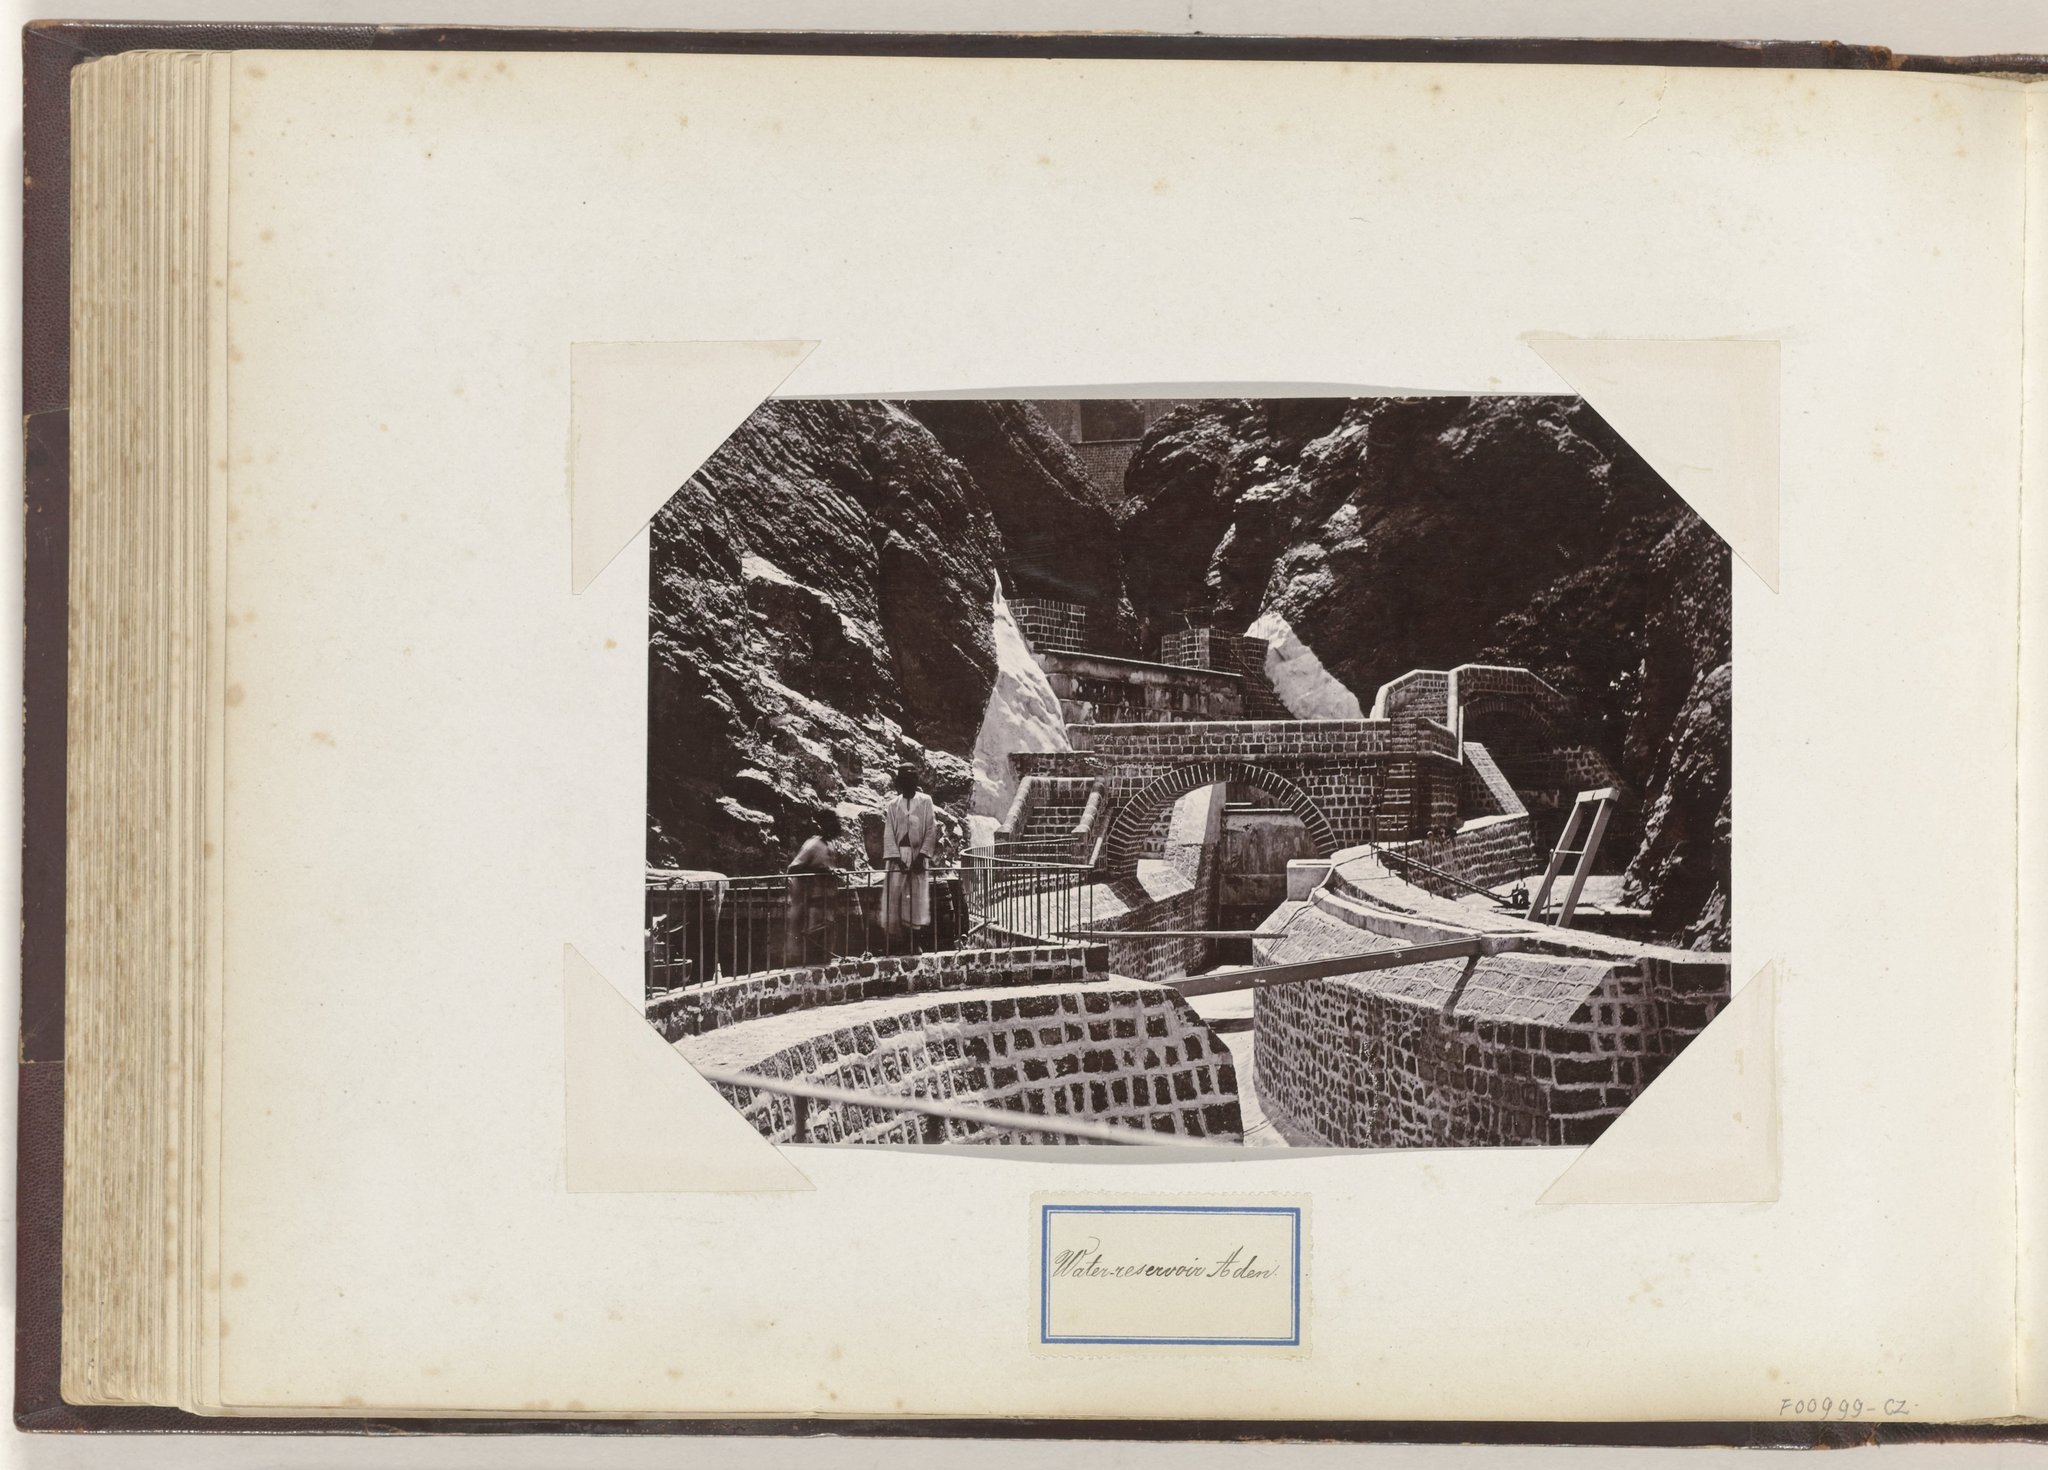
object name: photograph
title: Water-reservoir Aden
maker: Anonymous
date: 1880-1920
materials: paper, photographic support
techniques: gelatin silver print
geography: aden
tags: water-supply (~ public services)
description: Onderdeel van Album met 191 foto's van een reis naar en door Zuid-Afrika.